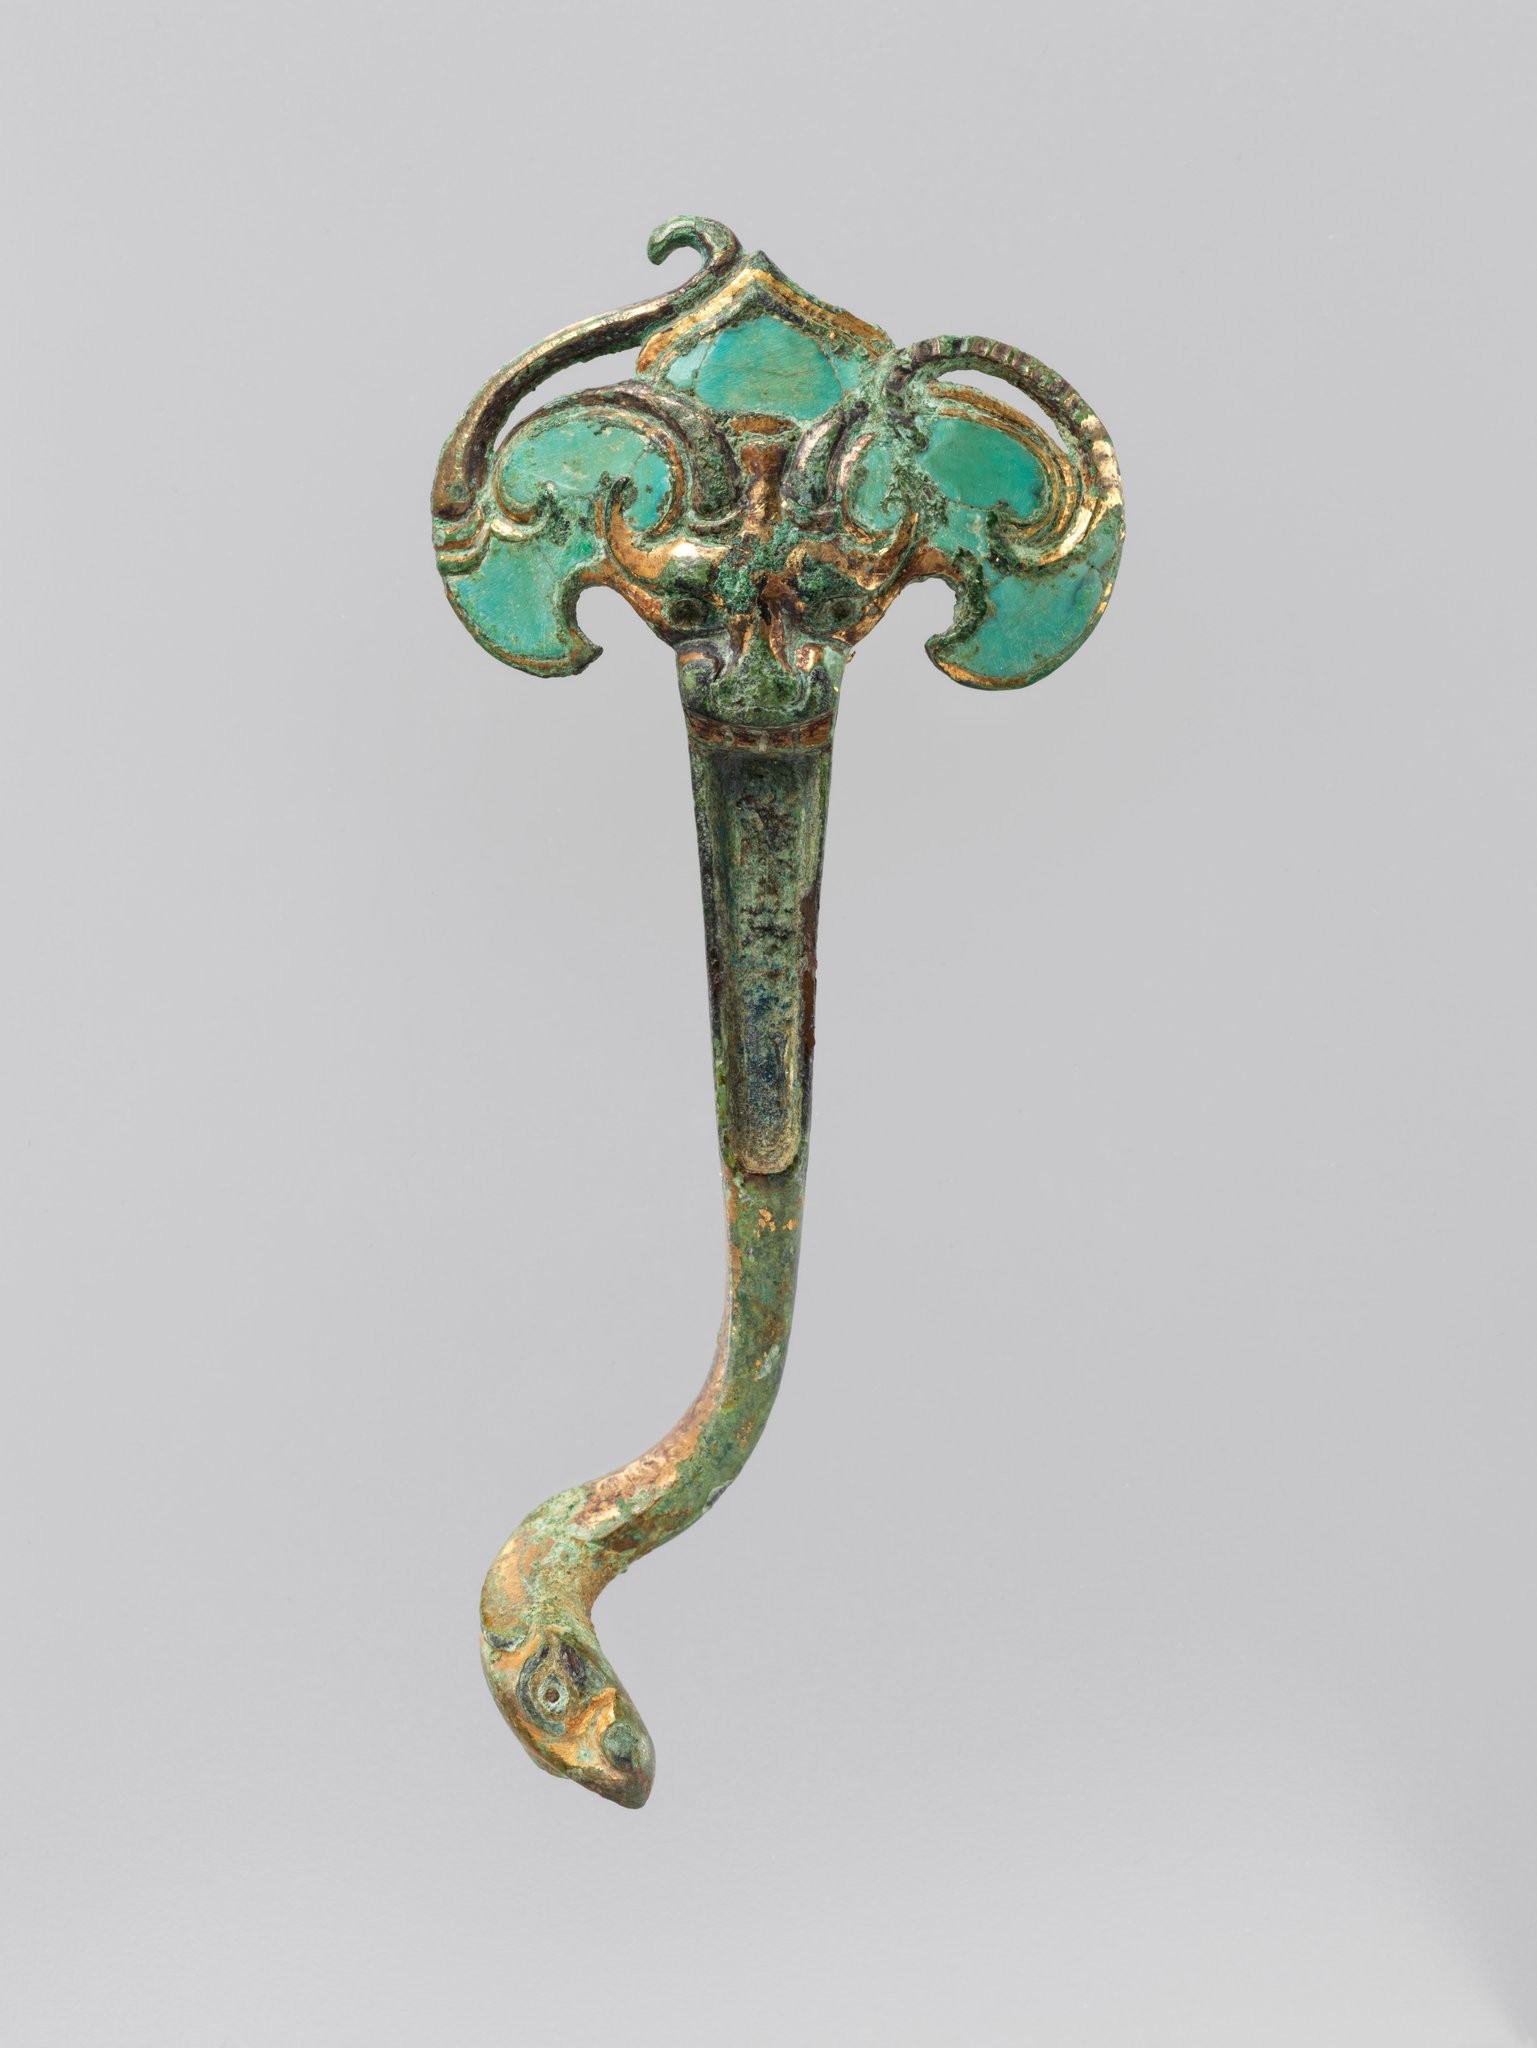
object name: belt hook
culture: chinese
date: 400-101 BCE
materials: gilt bronze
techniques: inlay